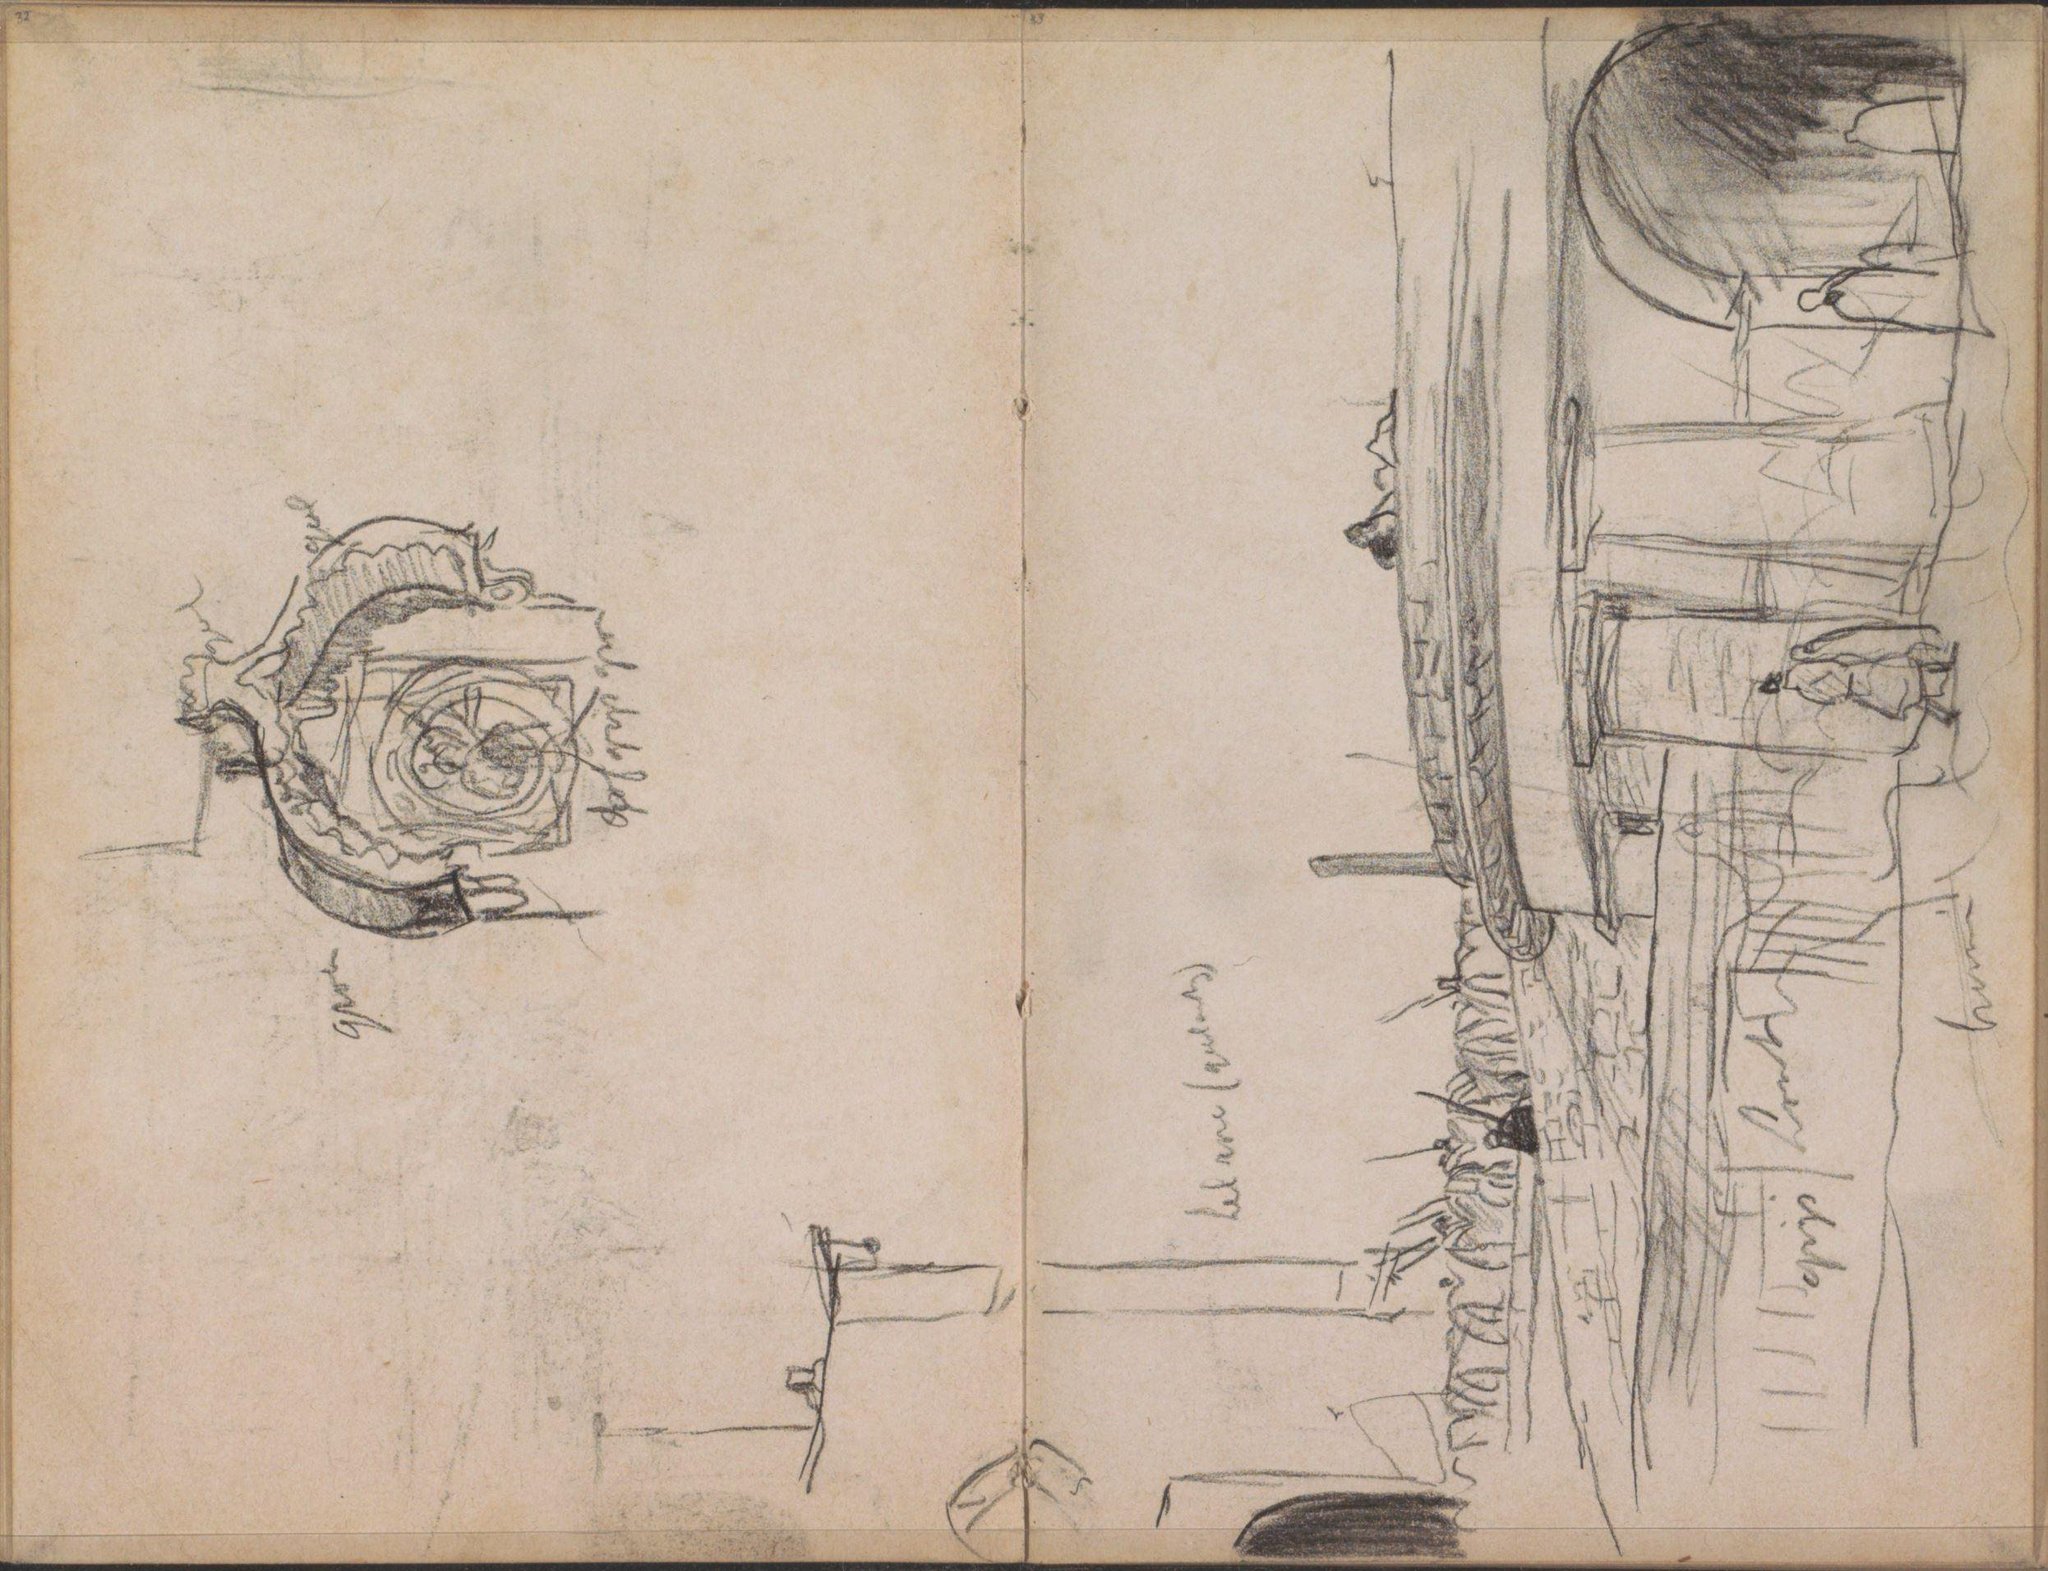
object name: sketchbook leaf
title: Muur met zuilen en een poort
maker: marius bauer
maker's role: draughtsman, print maker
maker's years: 1867-1932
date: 1896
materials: chalk, paper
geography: moscow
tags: column, pillar ~ architecture, arch, archivolt ~ architecture, walls ~ fortified city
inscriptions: kleurnotitie, handgeschreven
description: Mogelijk een deel van de muur rondom het Kremlin van Moskou. Pagina 33 uit een schetsboek met 45 bladen.